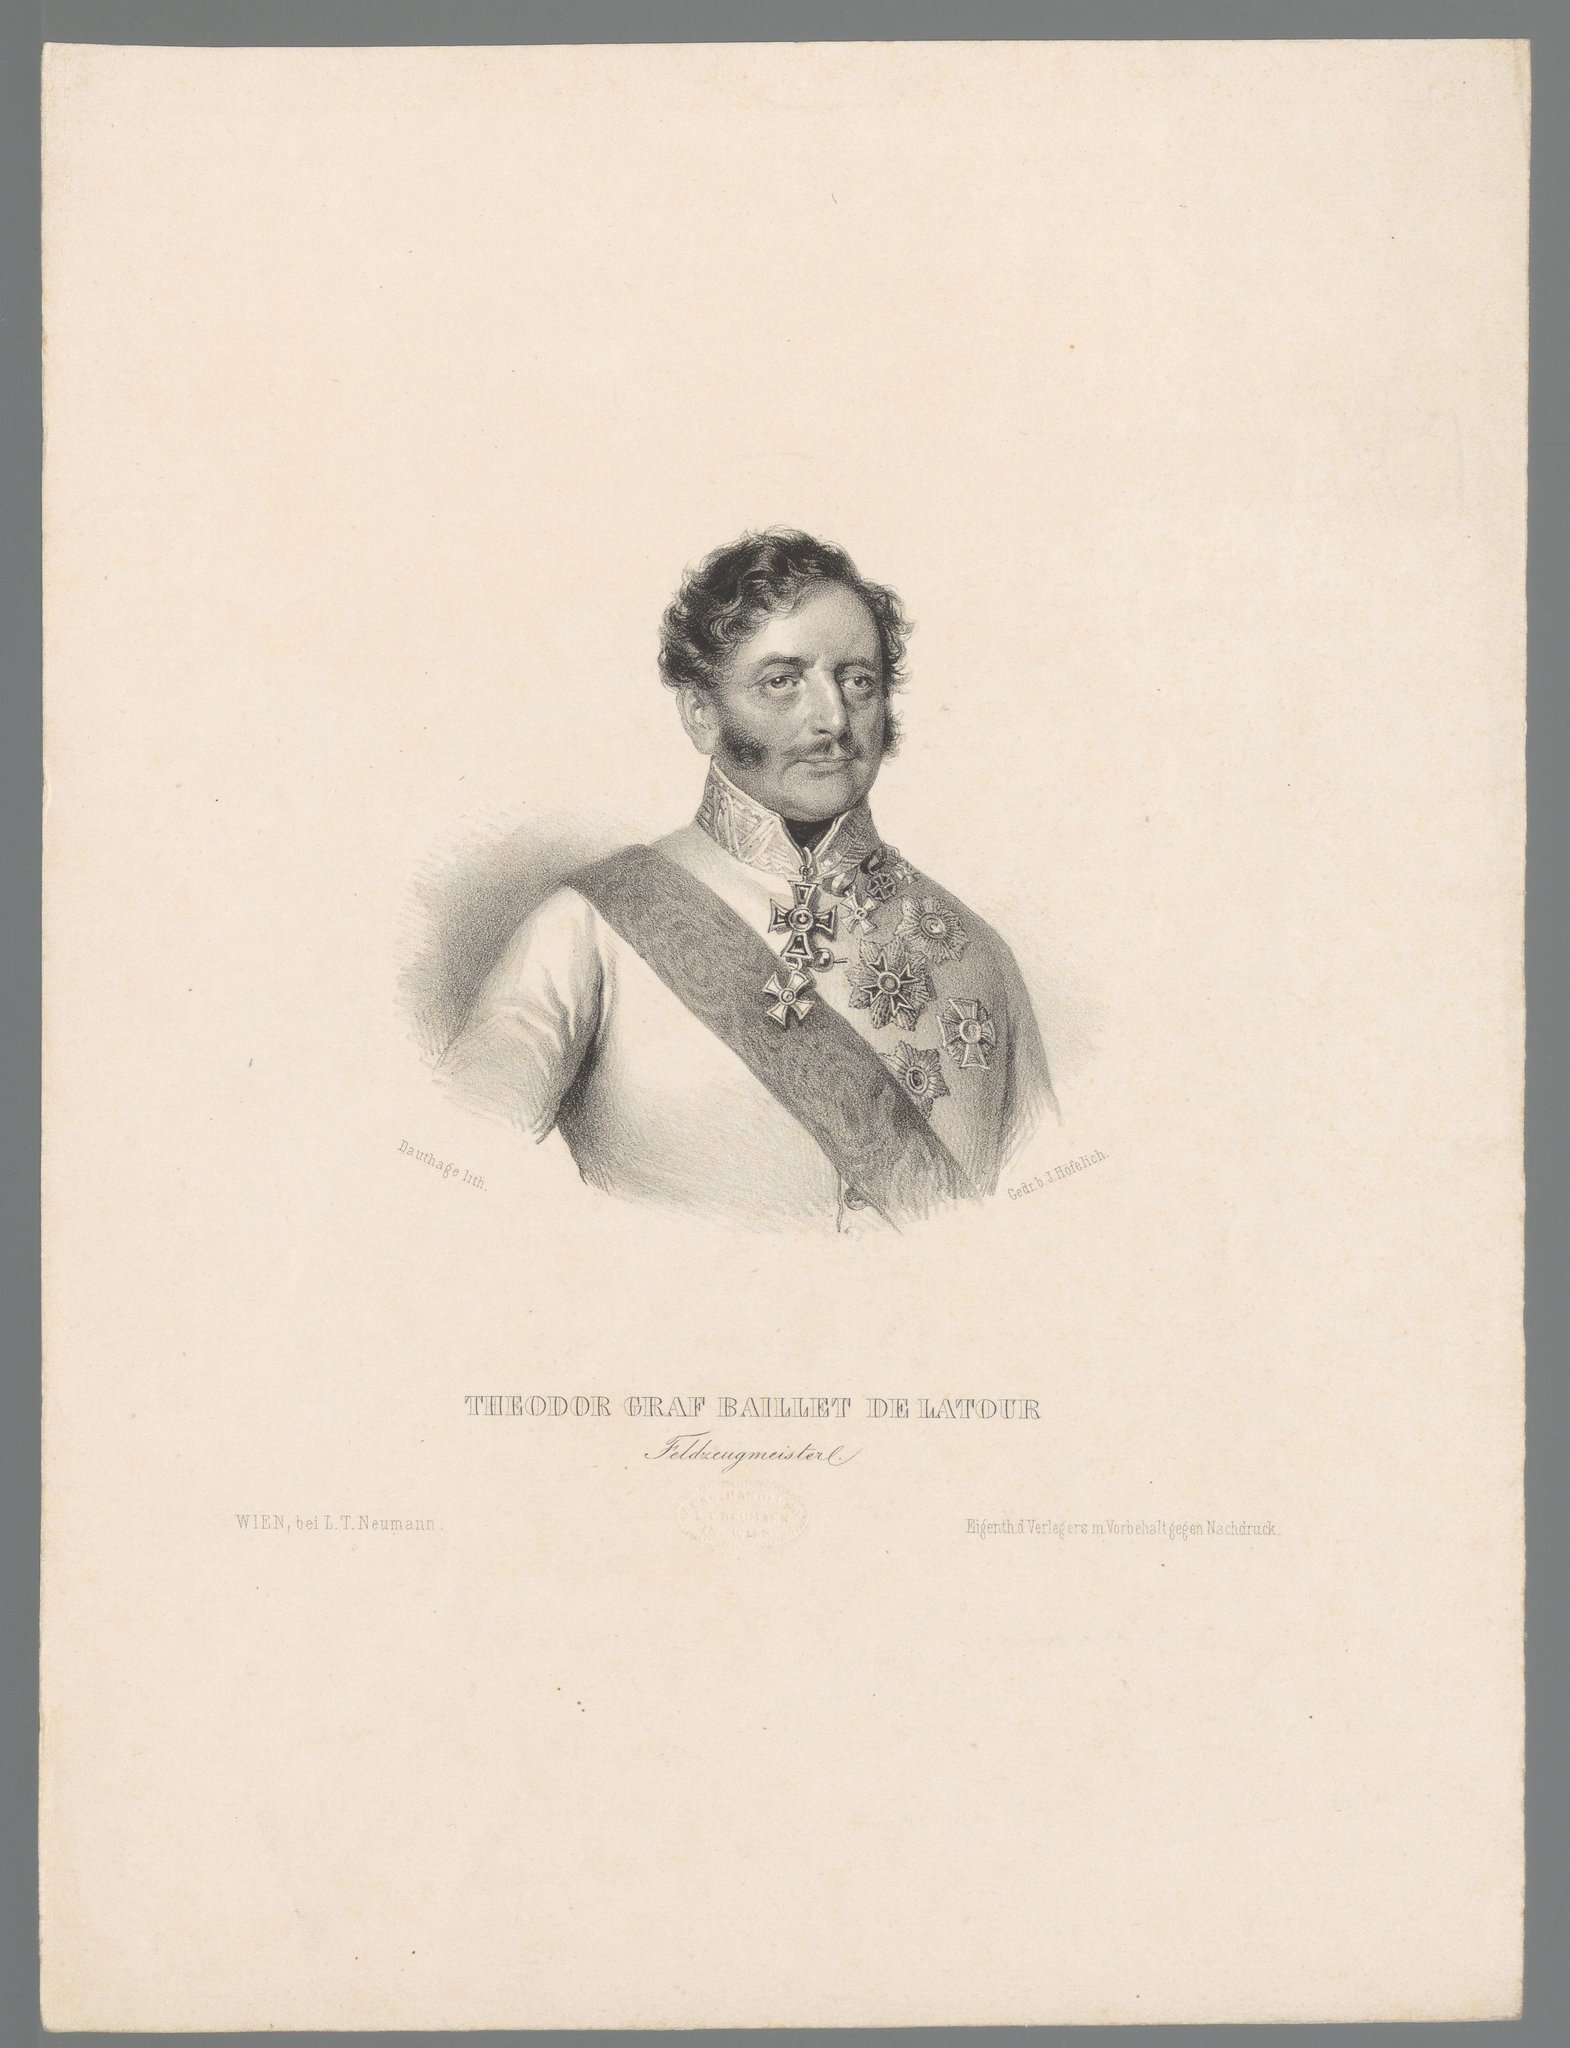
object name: print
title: Theodor Graf Baillet de Latour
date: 1835-1849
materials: paper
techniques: lithograph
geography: vienna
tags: commander-in-chief, general, marshal, historical persons, politician, e.g. party leader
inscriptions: check stamp: ‘Kunsthandlung L.T. Neumann im Wien’, collector's mark: Lugt 2228